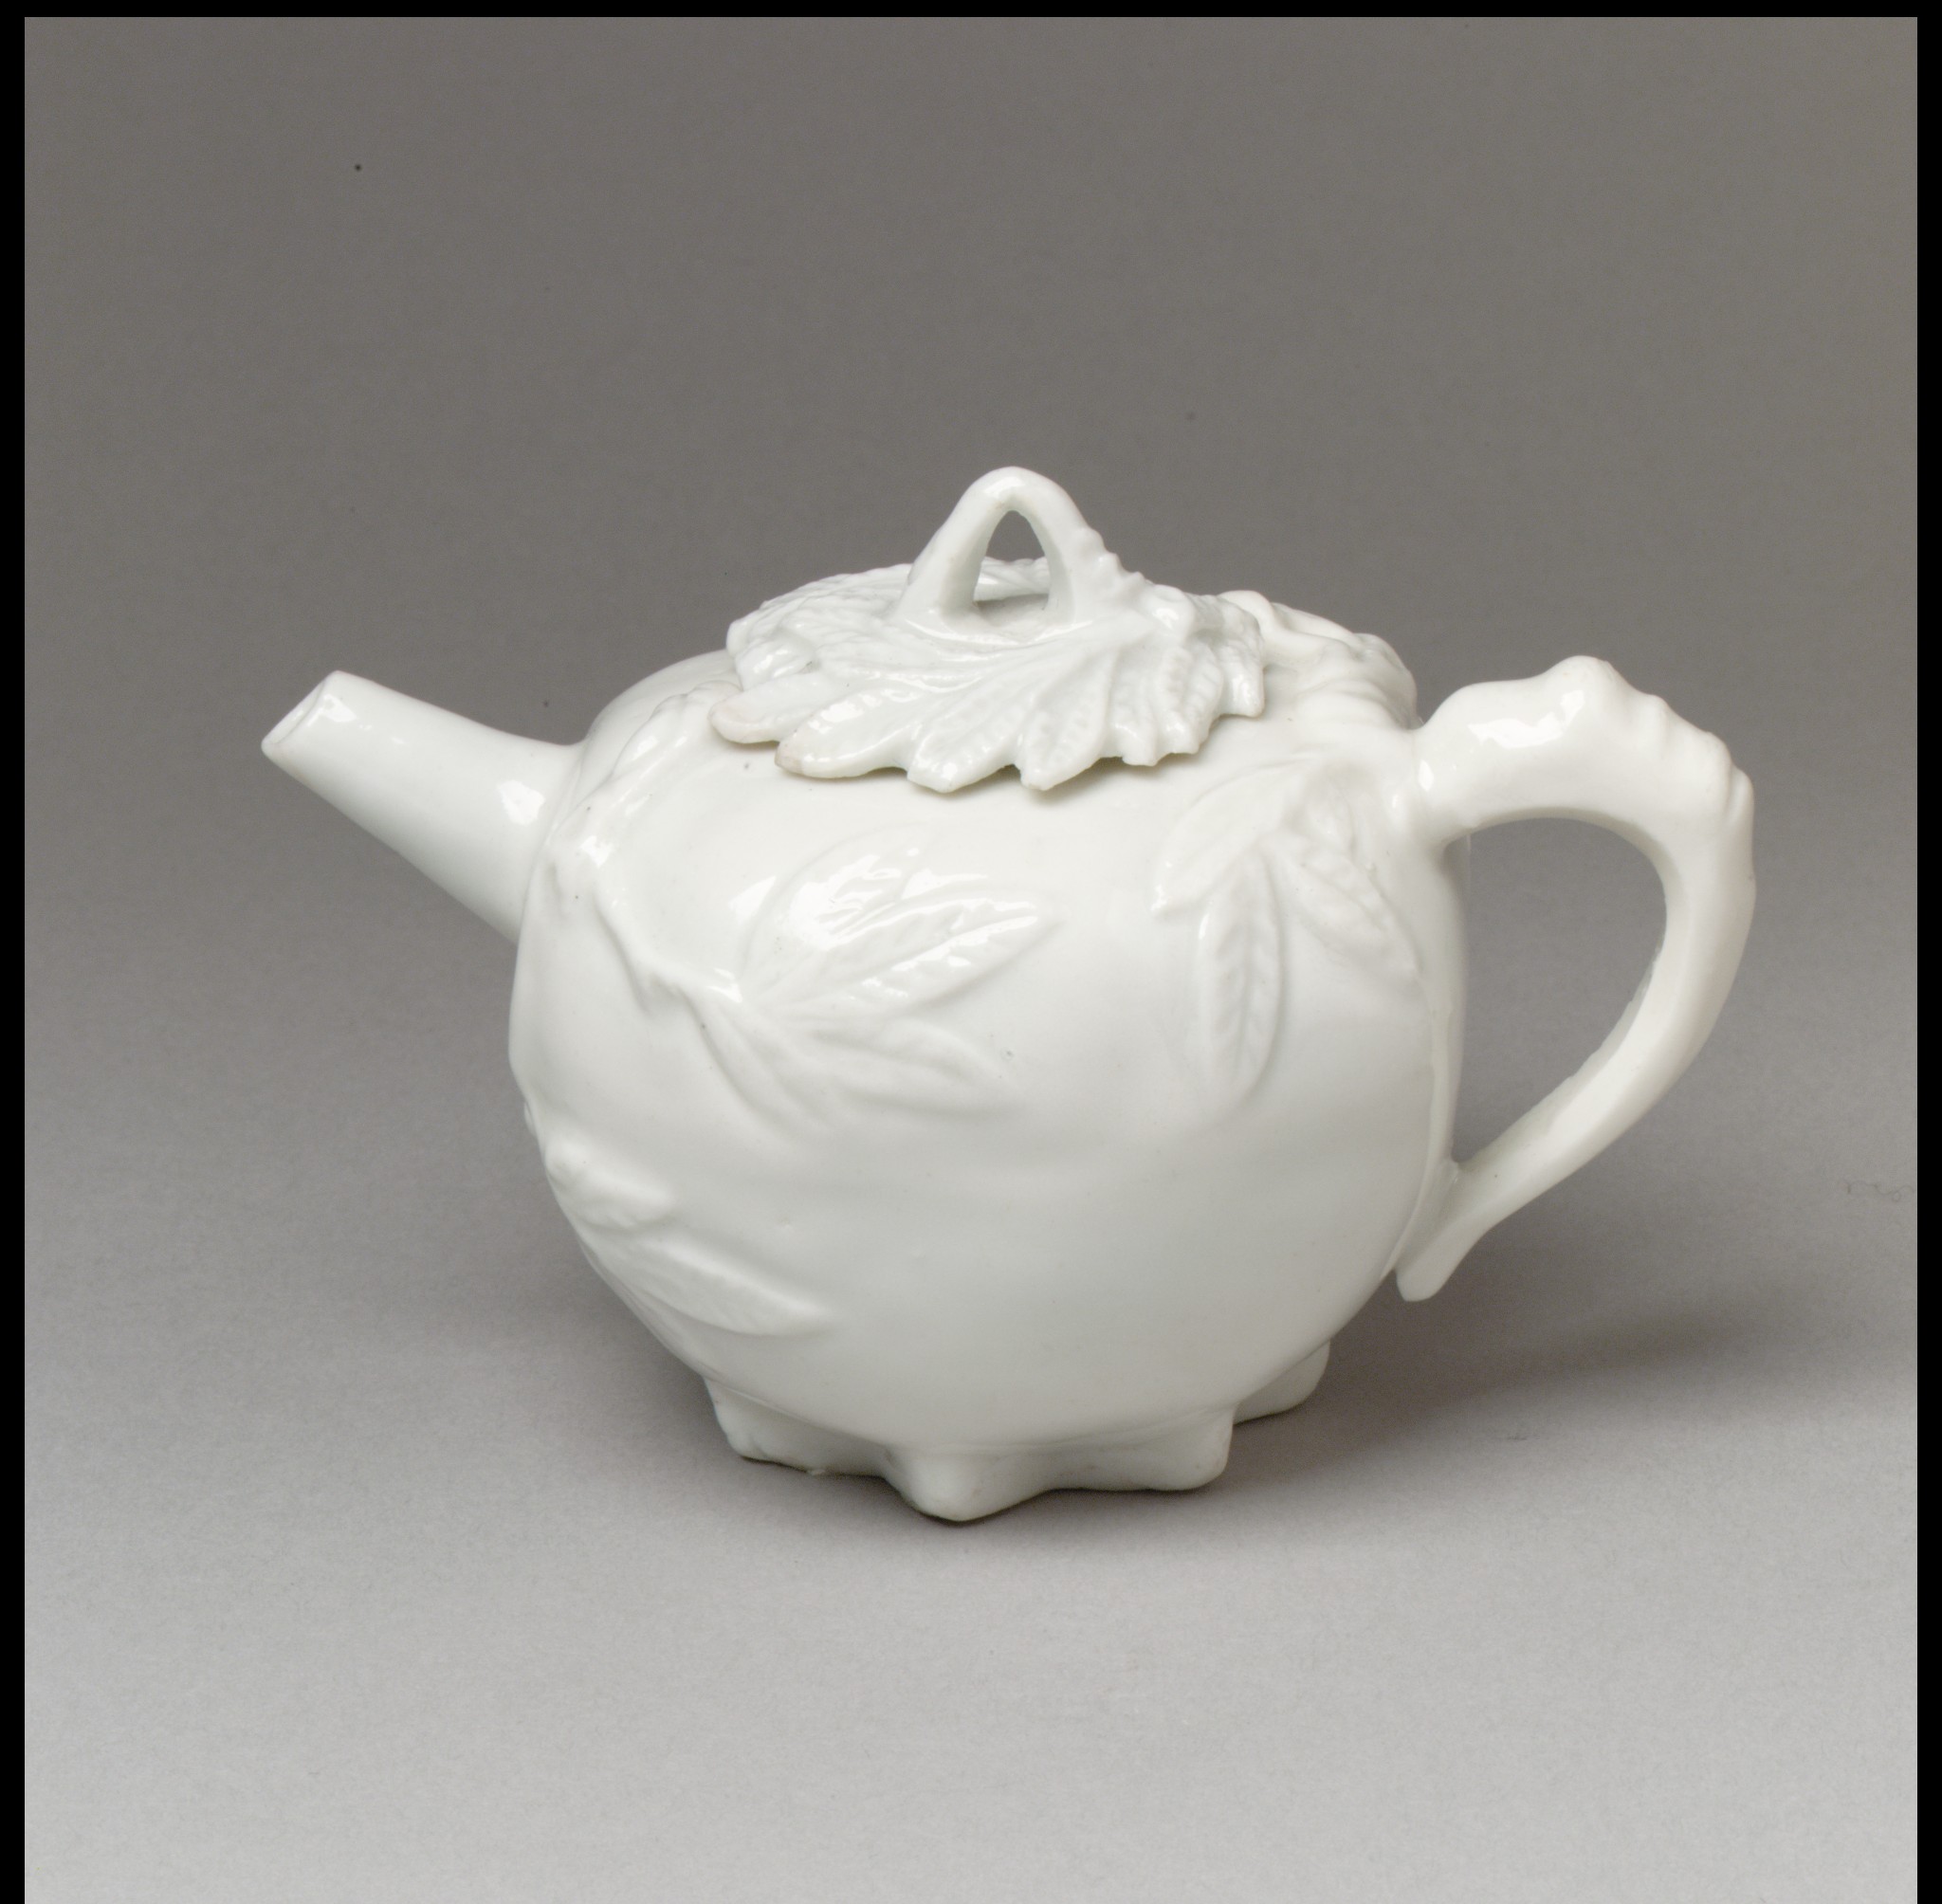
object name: teapot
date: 1701-1800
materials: hard paste porcelain